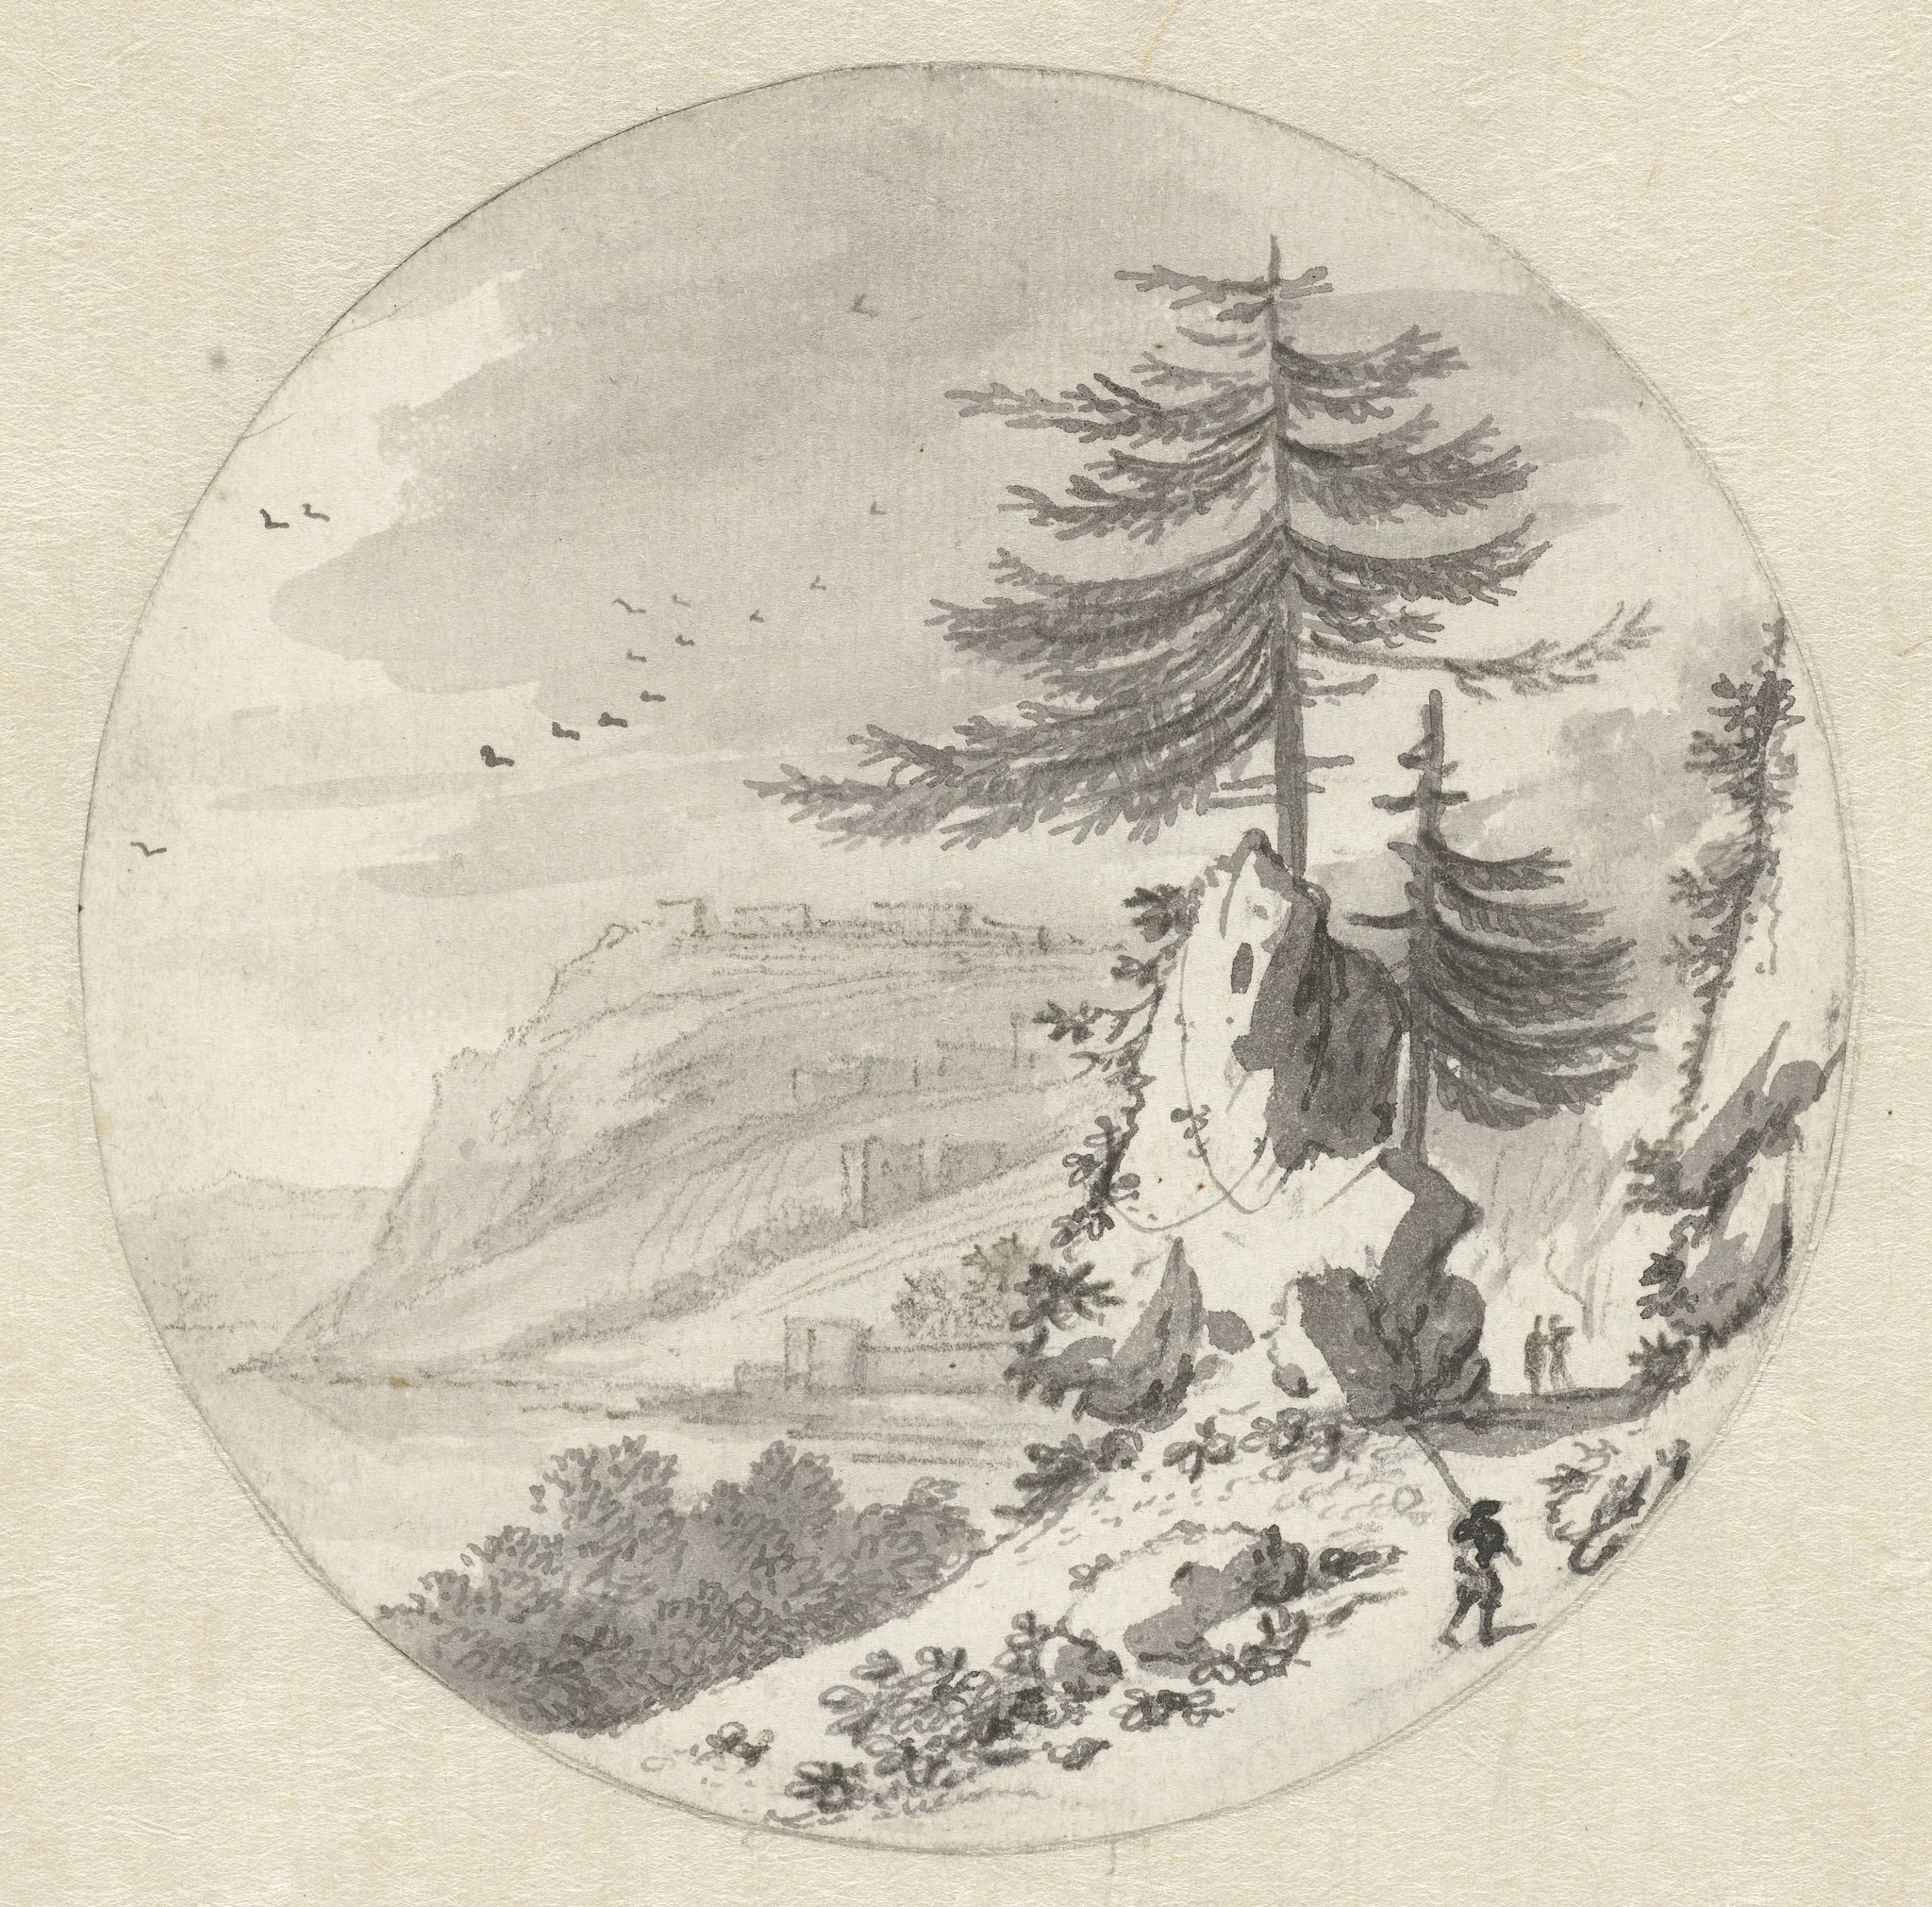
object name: drawing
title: Mountainous Coastal Landscape with a Large Fir Tree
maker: hendrik van der straaten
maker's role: draughtsman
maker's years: 1665-1722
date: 1687-1689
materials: chalk, ink, paper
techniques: brush, pen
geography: haarlem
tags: low hill country